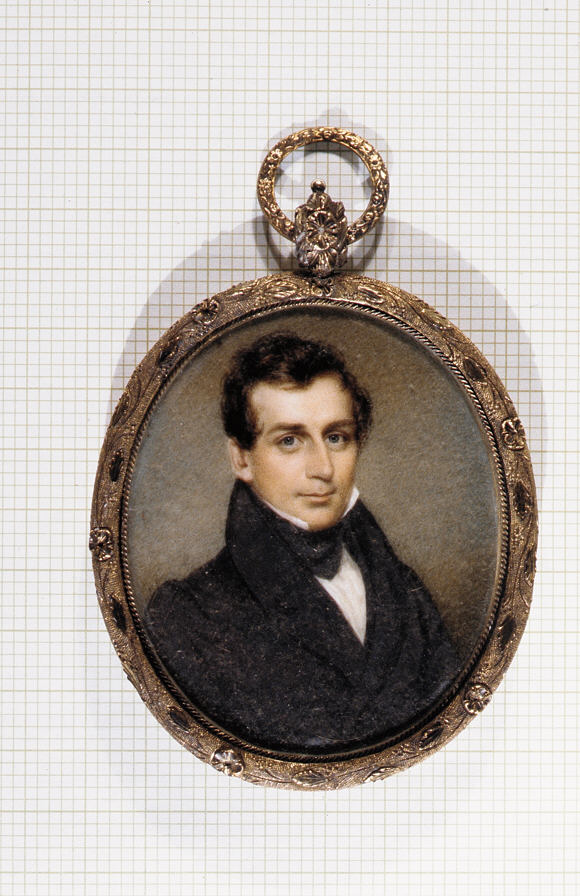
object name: painting, miniature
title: Portrait of a Gentleman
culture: american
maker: nathaniel rogers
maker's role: artist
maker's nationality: american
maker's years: 1788-1844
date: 1835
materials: ivory, watercolor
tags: men,portraits